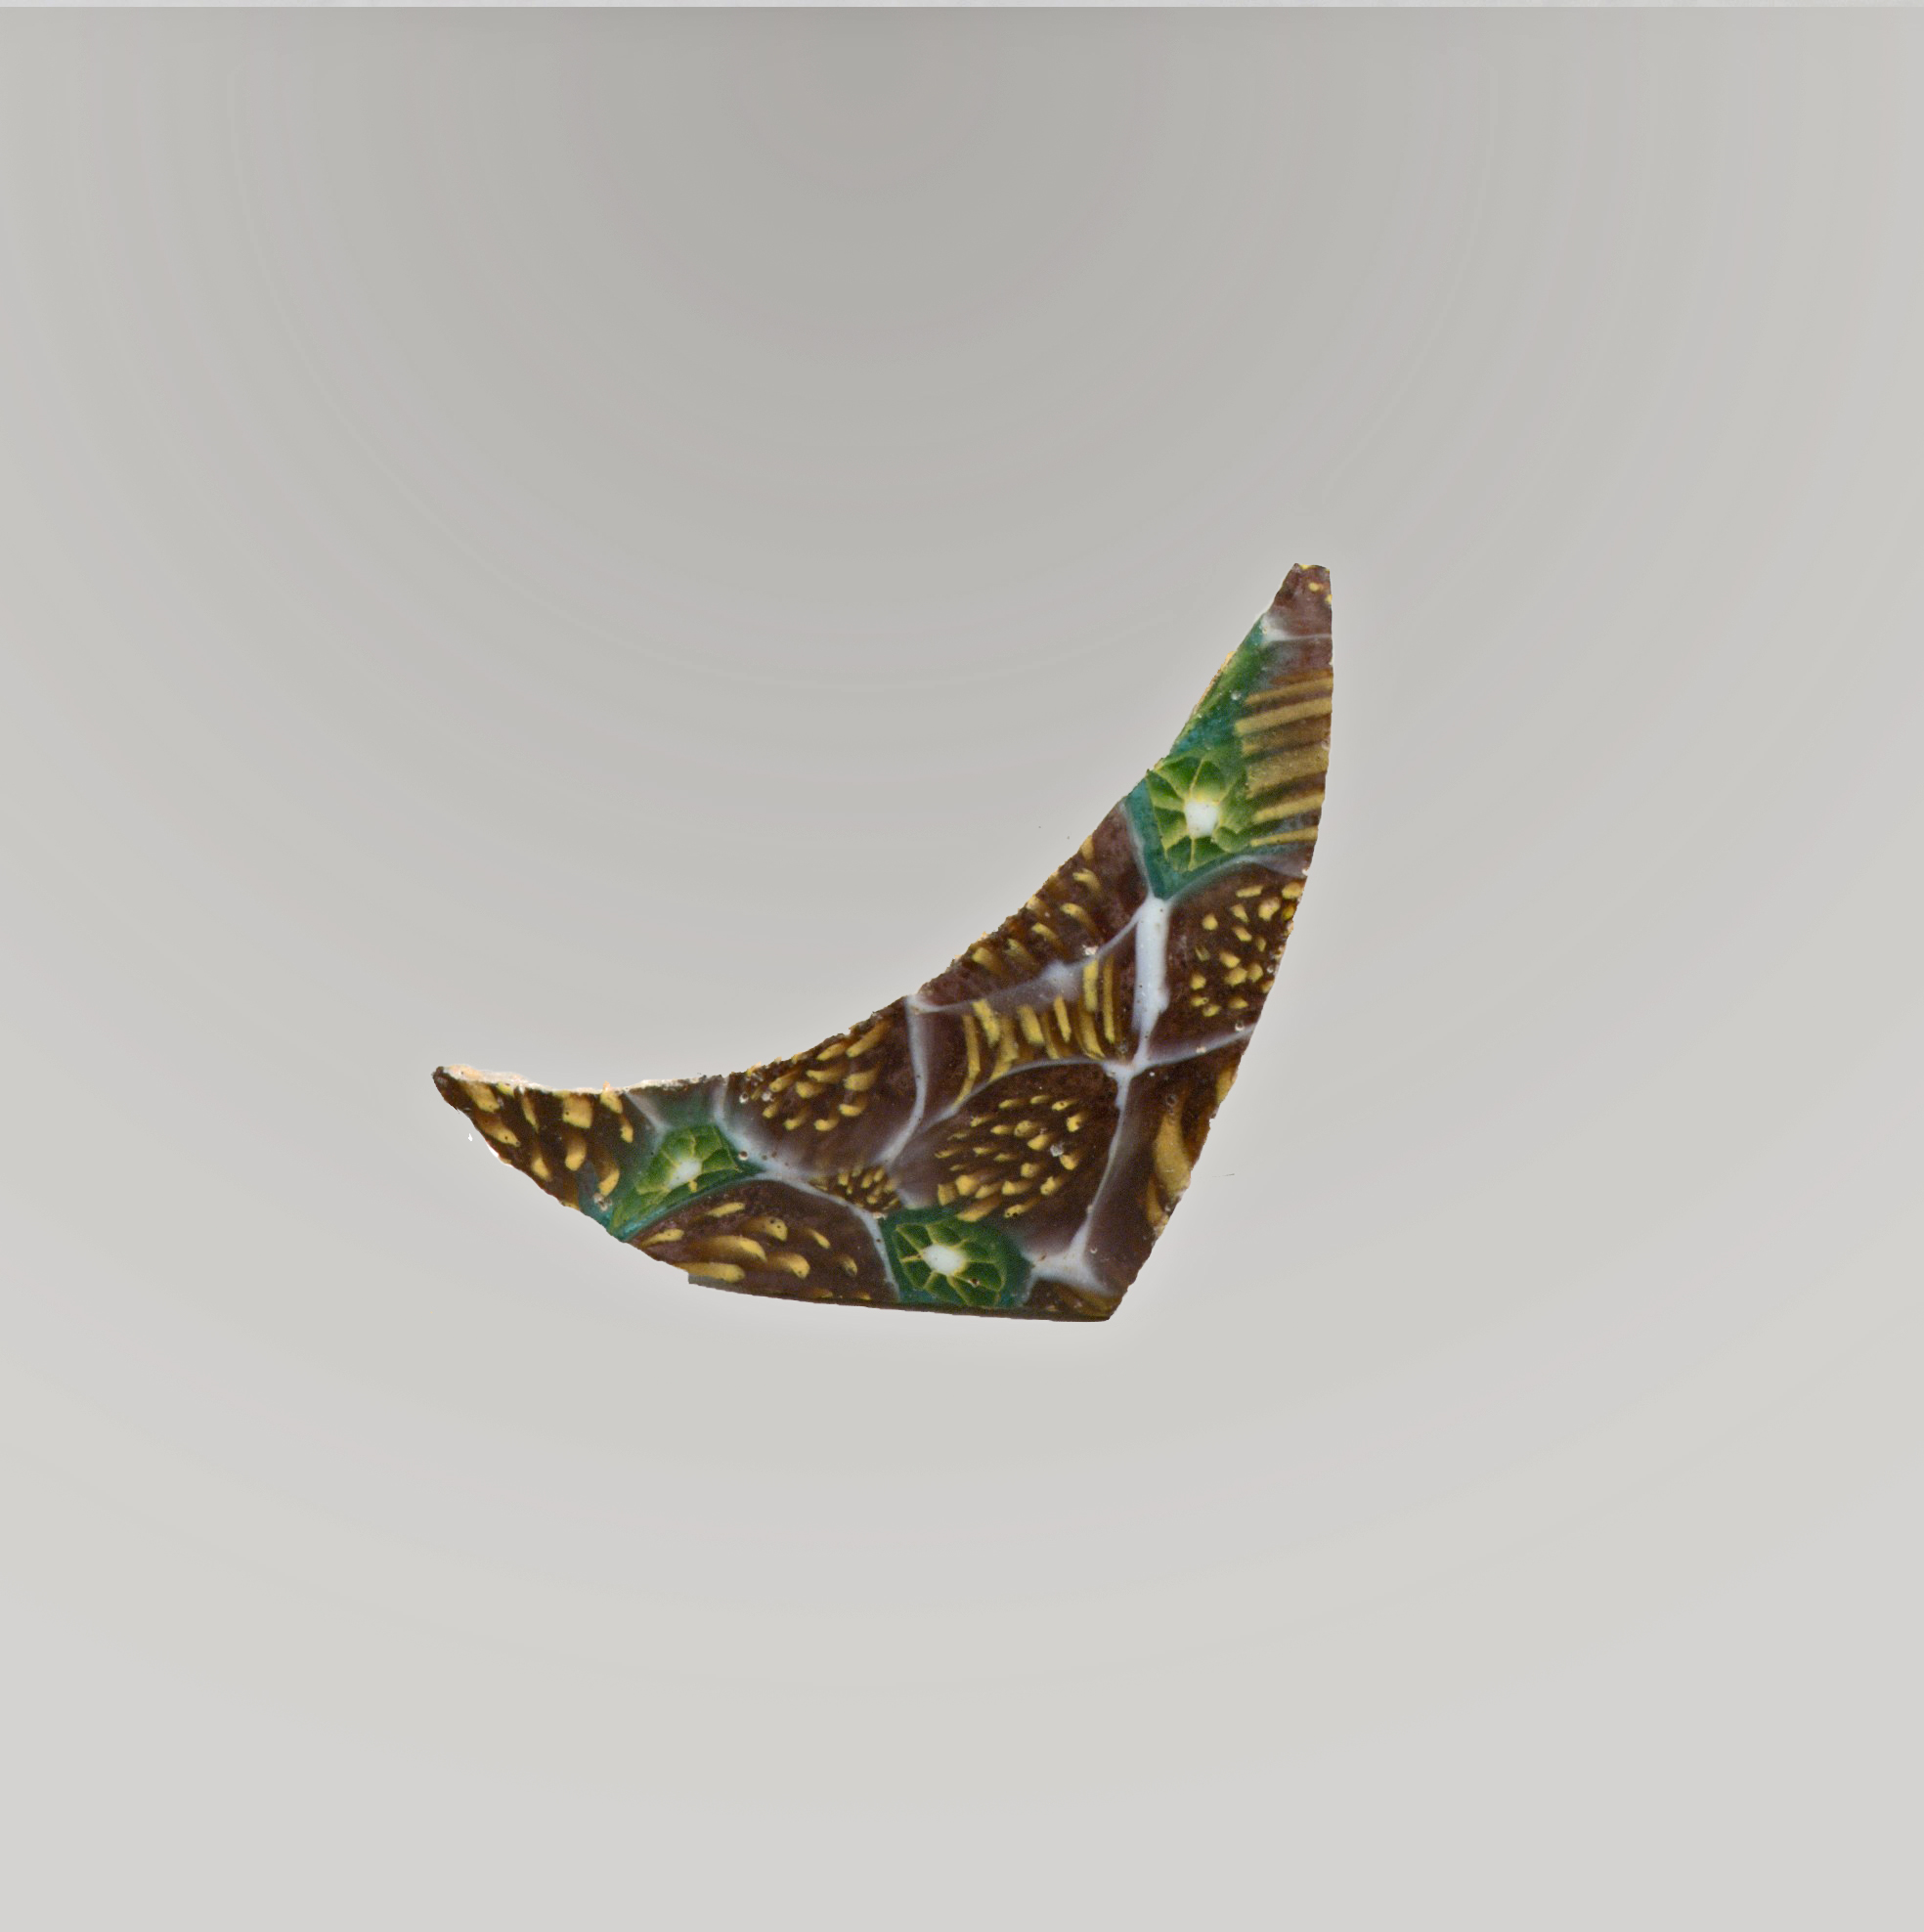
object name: fragment, mosaic bowl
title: Glass mosaic bowl fragment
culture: roman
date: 34 BCE-33 CE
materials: glass